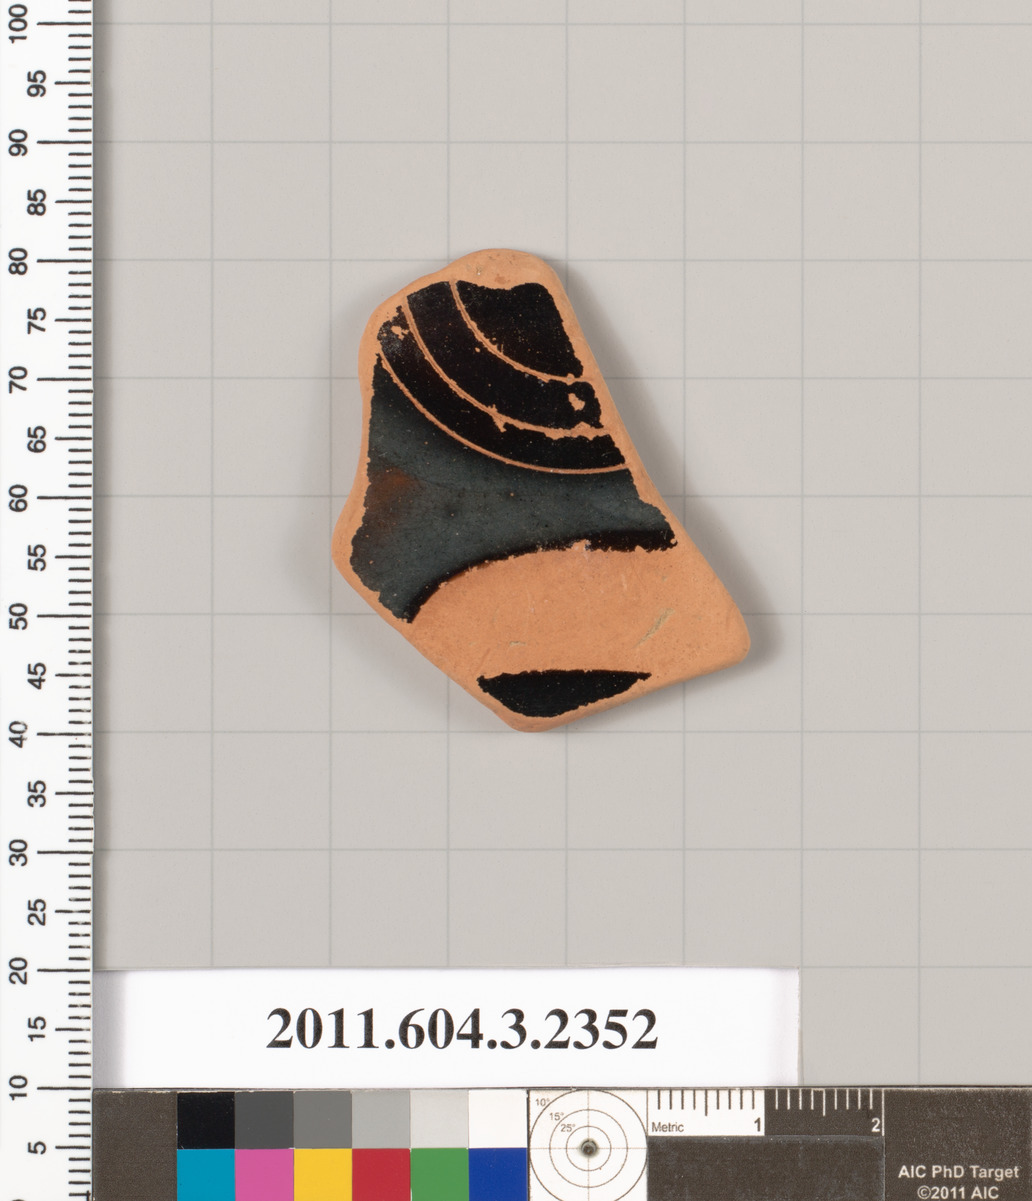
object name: kylix fragment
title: Terracotta fragment of a kylix: eye-cup (drinking cup)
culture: greek, attic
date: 540-510 BCE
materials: terracotta